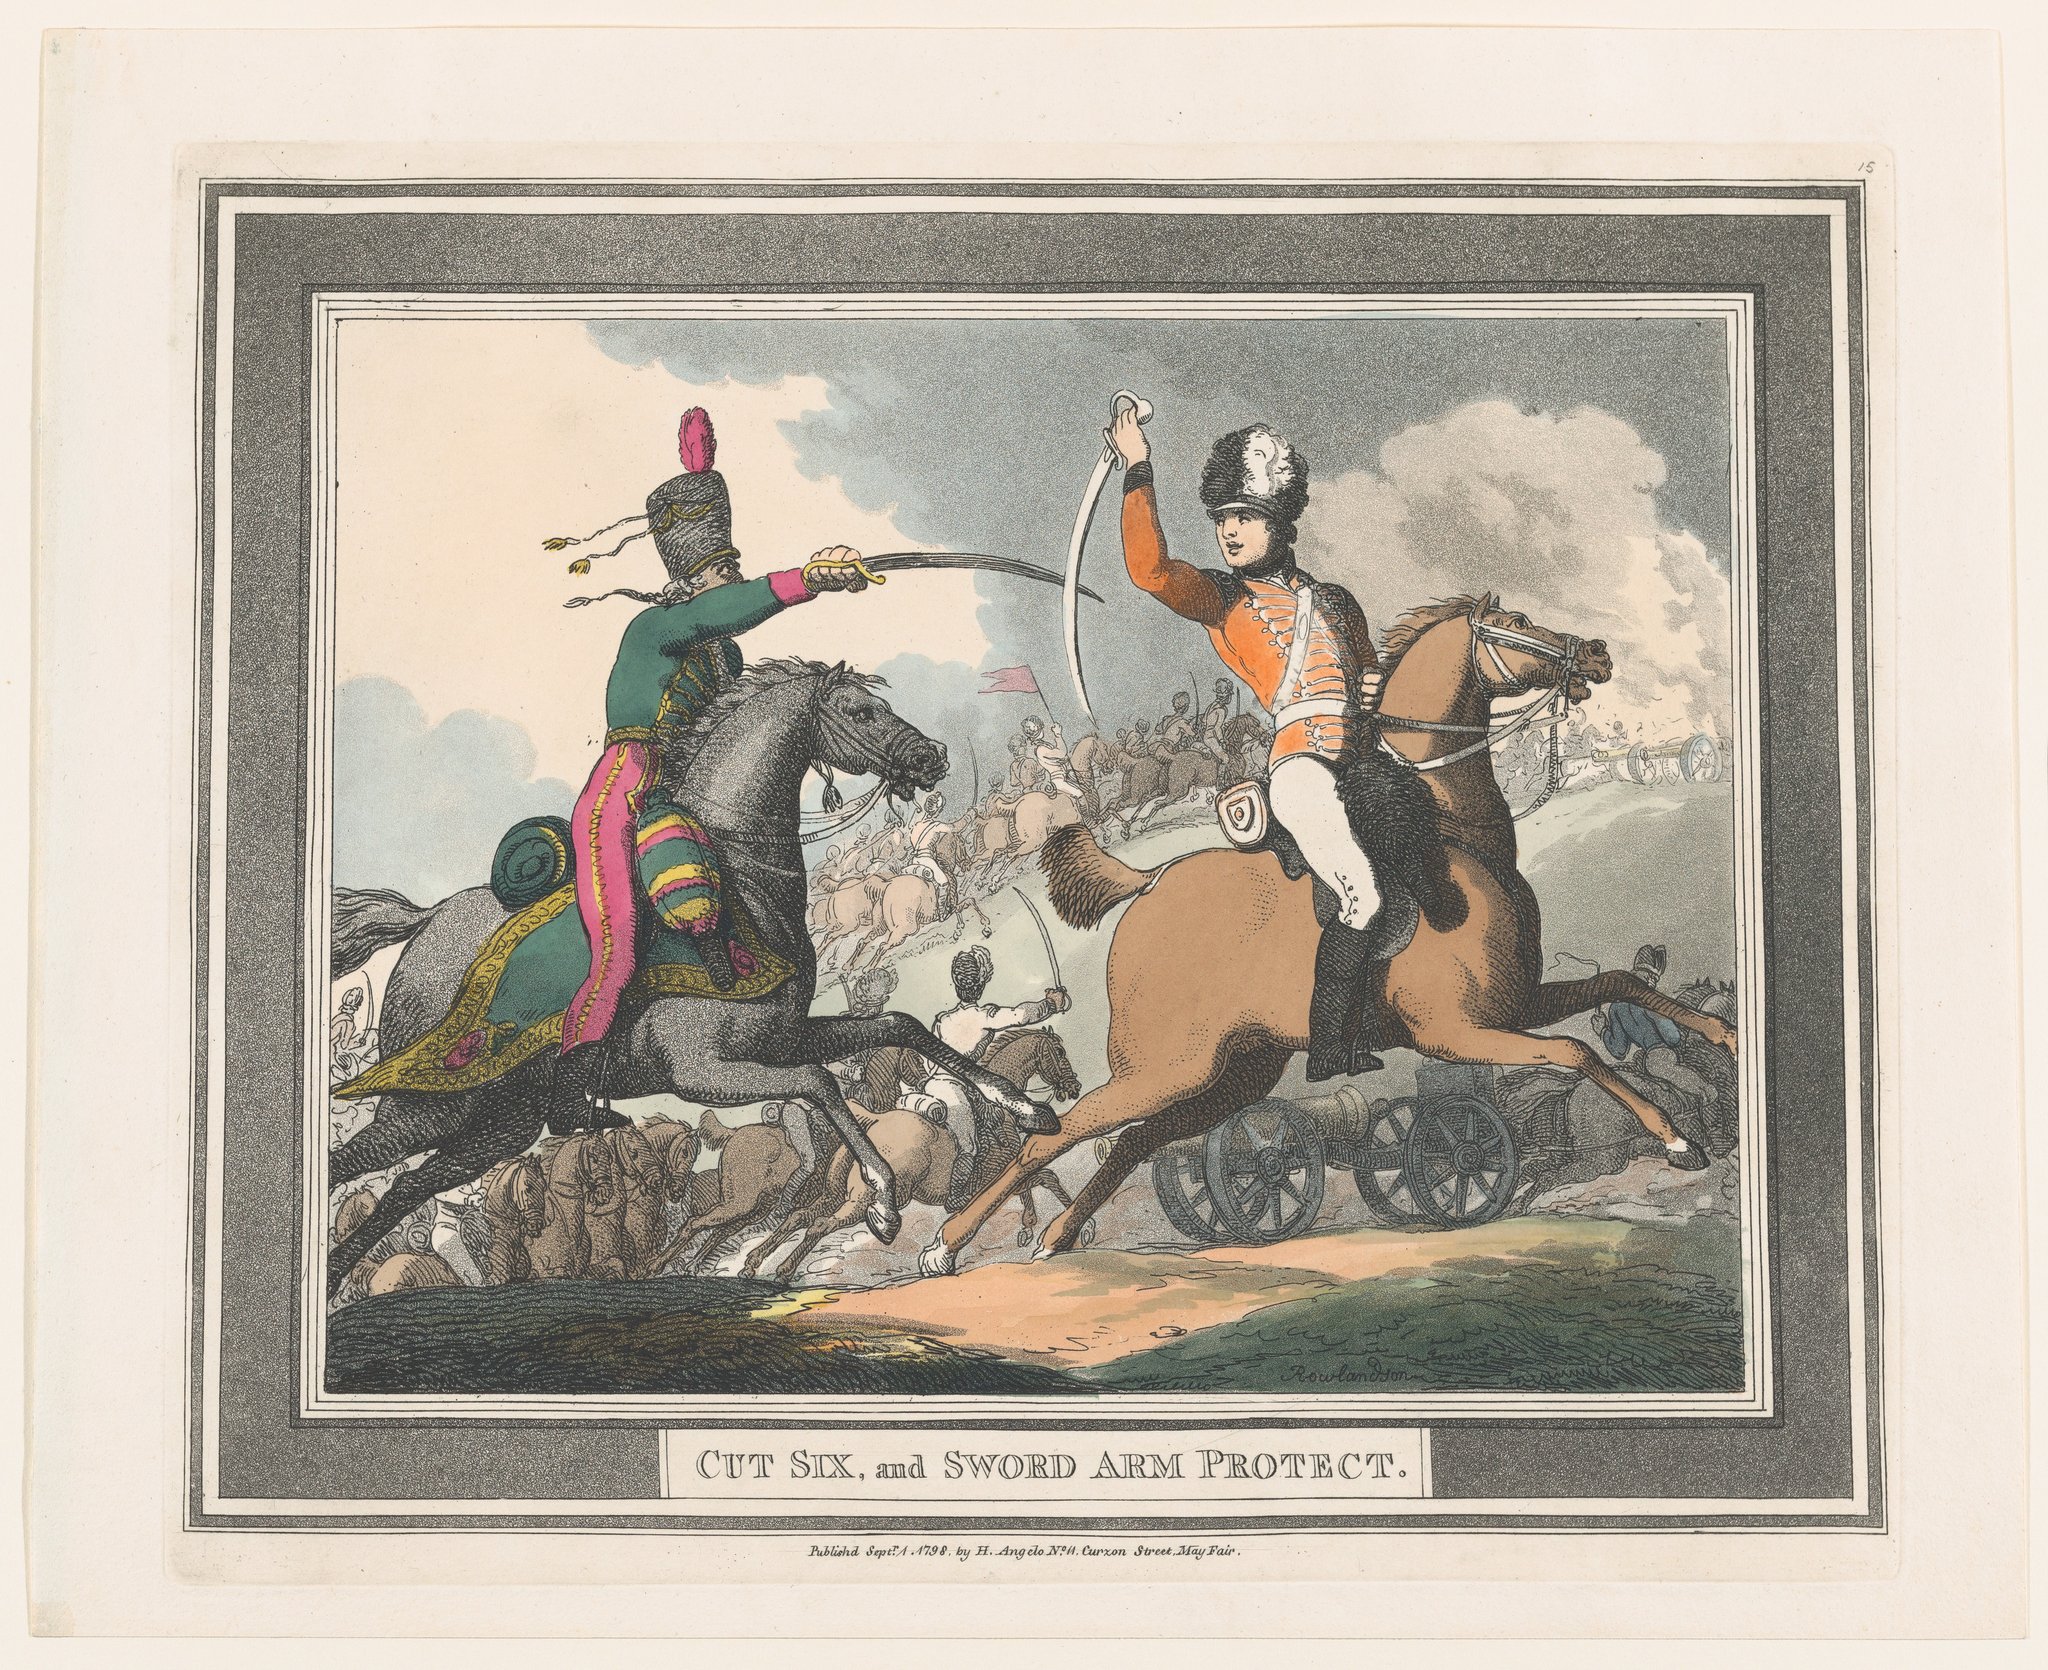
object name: print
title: Cut Six, and Sword Arm Protect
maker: thomas rowlandson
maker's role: artist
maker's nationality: british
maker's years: 1757-1827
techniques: aquatint, etching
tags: battles,soldiers,men,horses